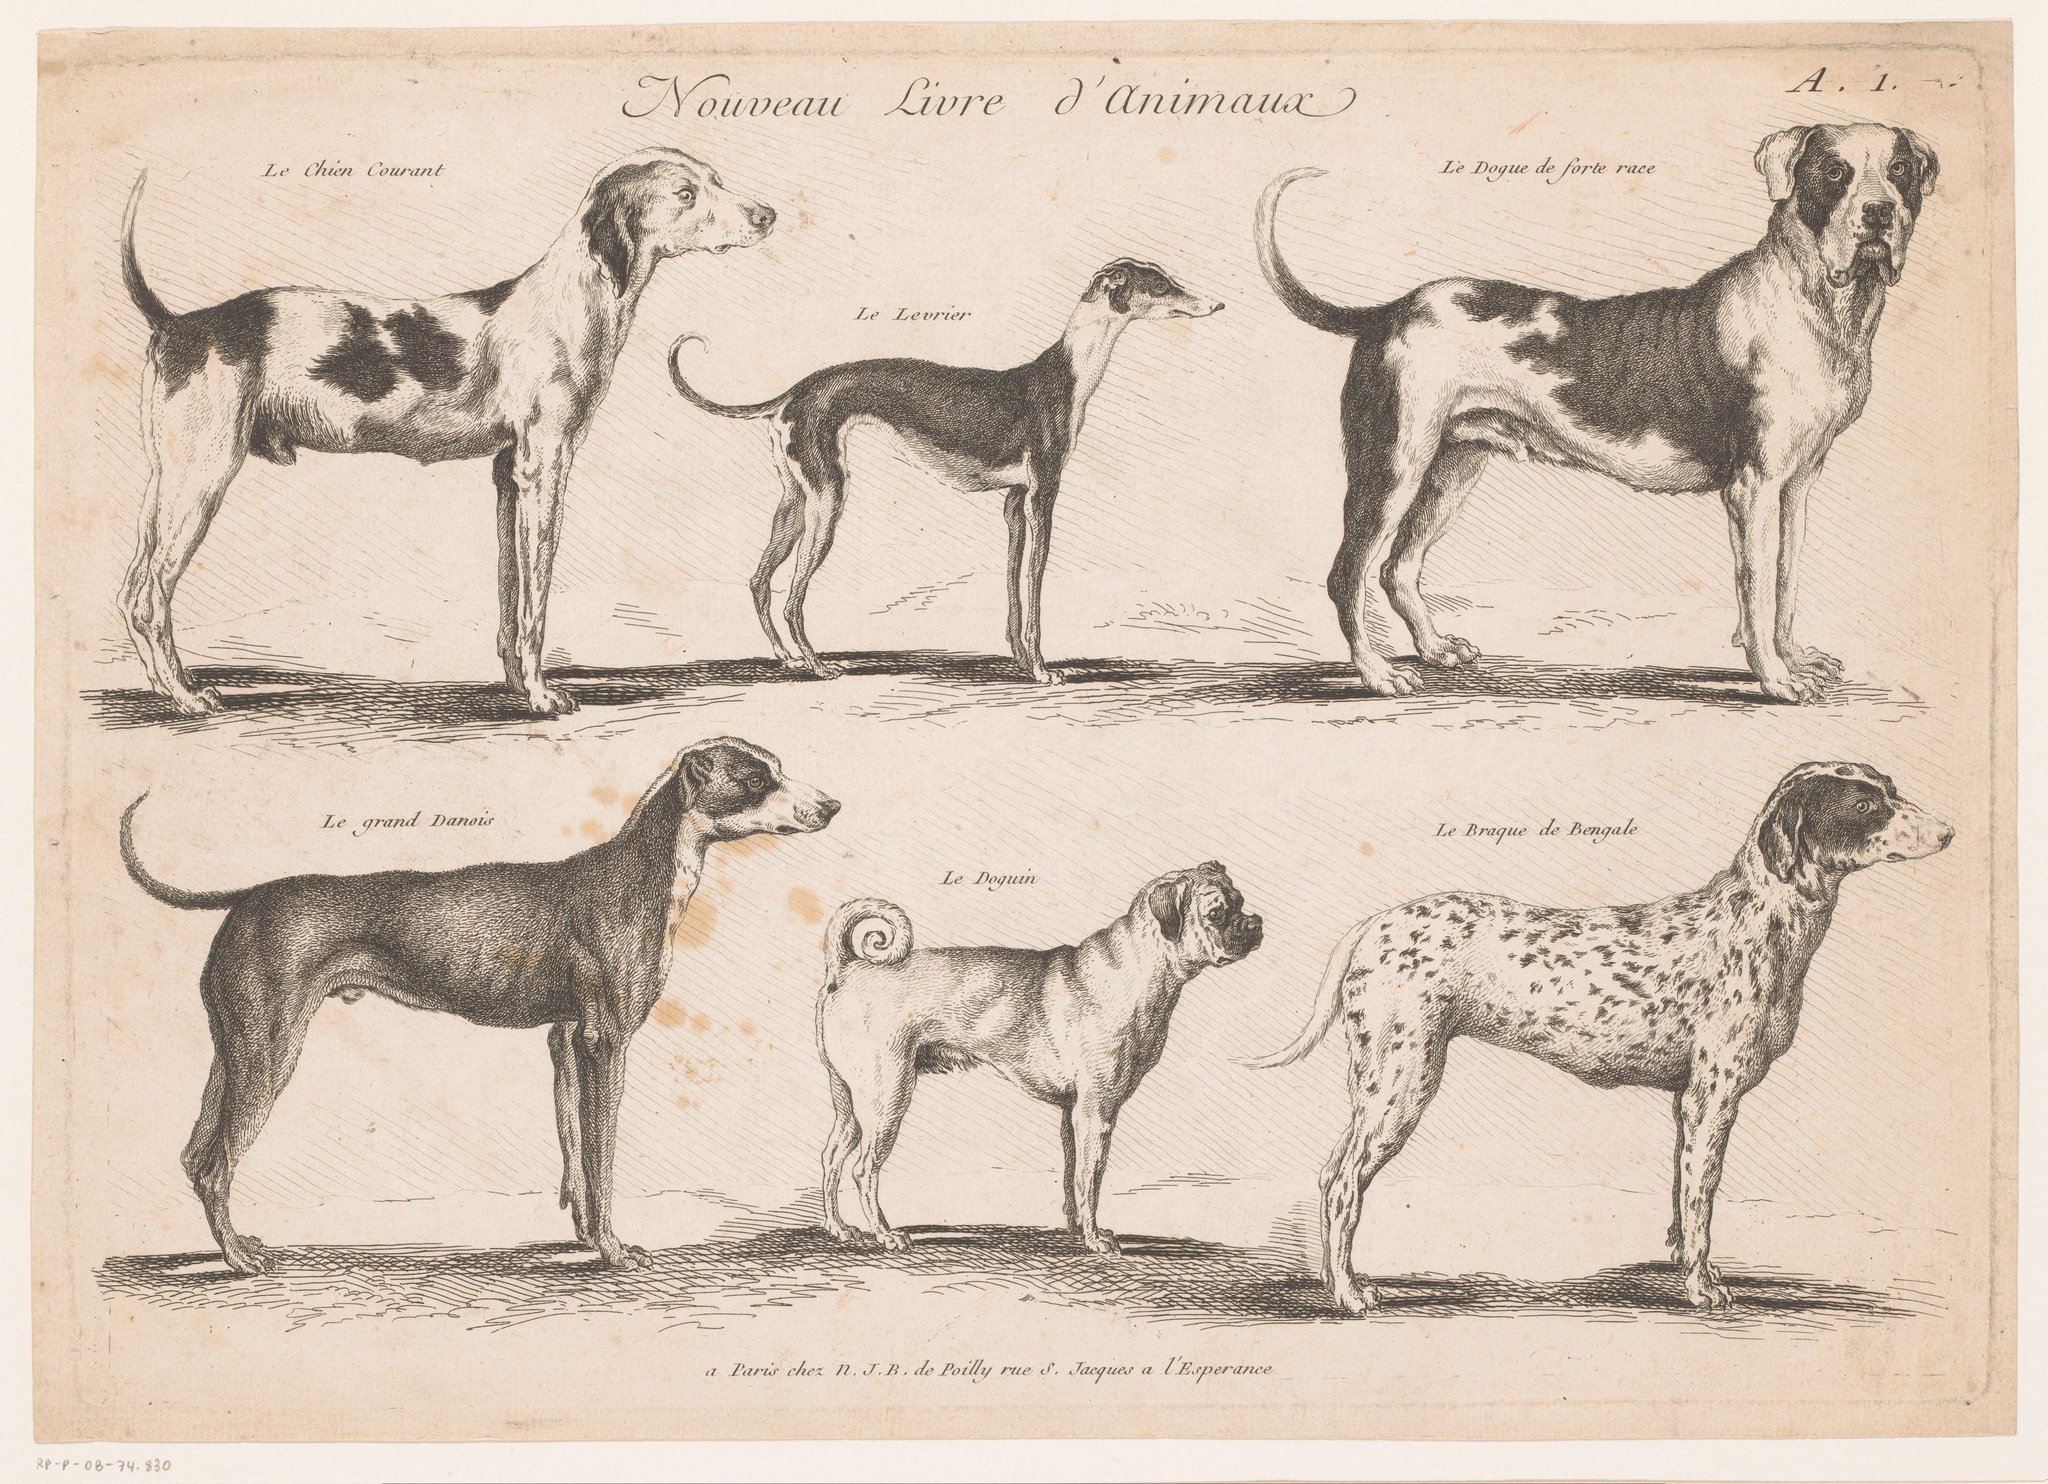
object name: print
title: Hondenrassen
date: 1750-1820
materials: paper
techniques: engraving, etching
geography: paris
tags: dog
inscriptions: collector's mark: Lugt 2228, watermark